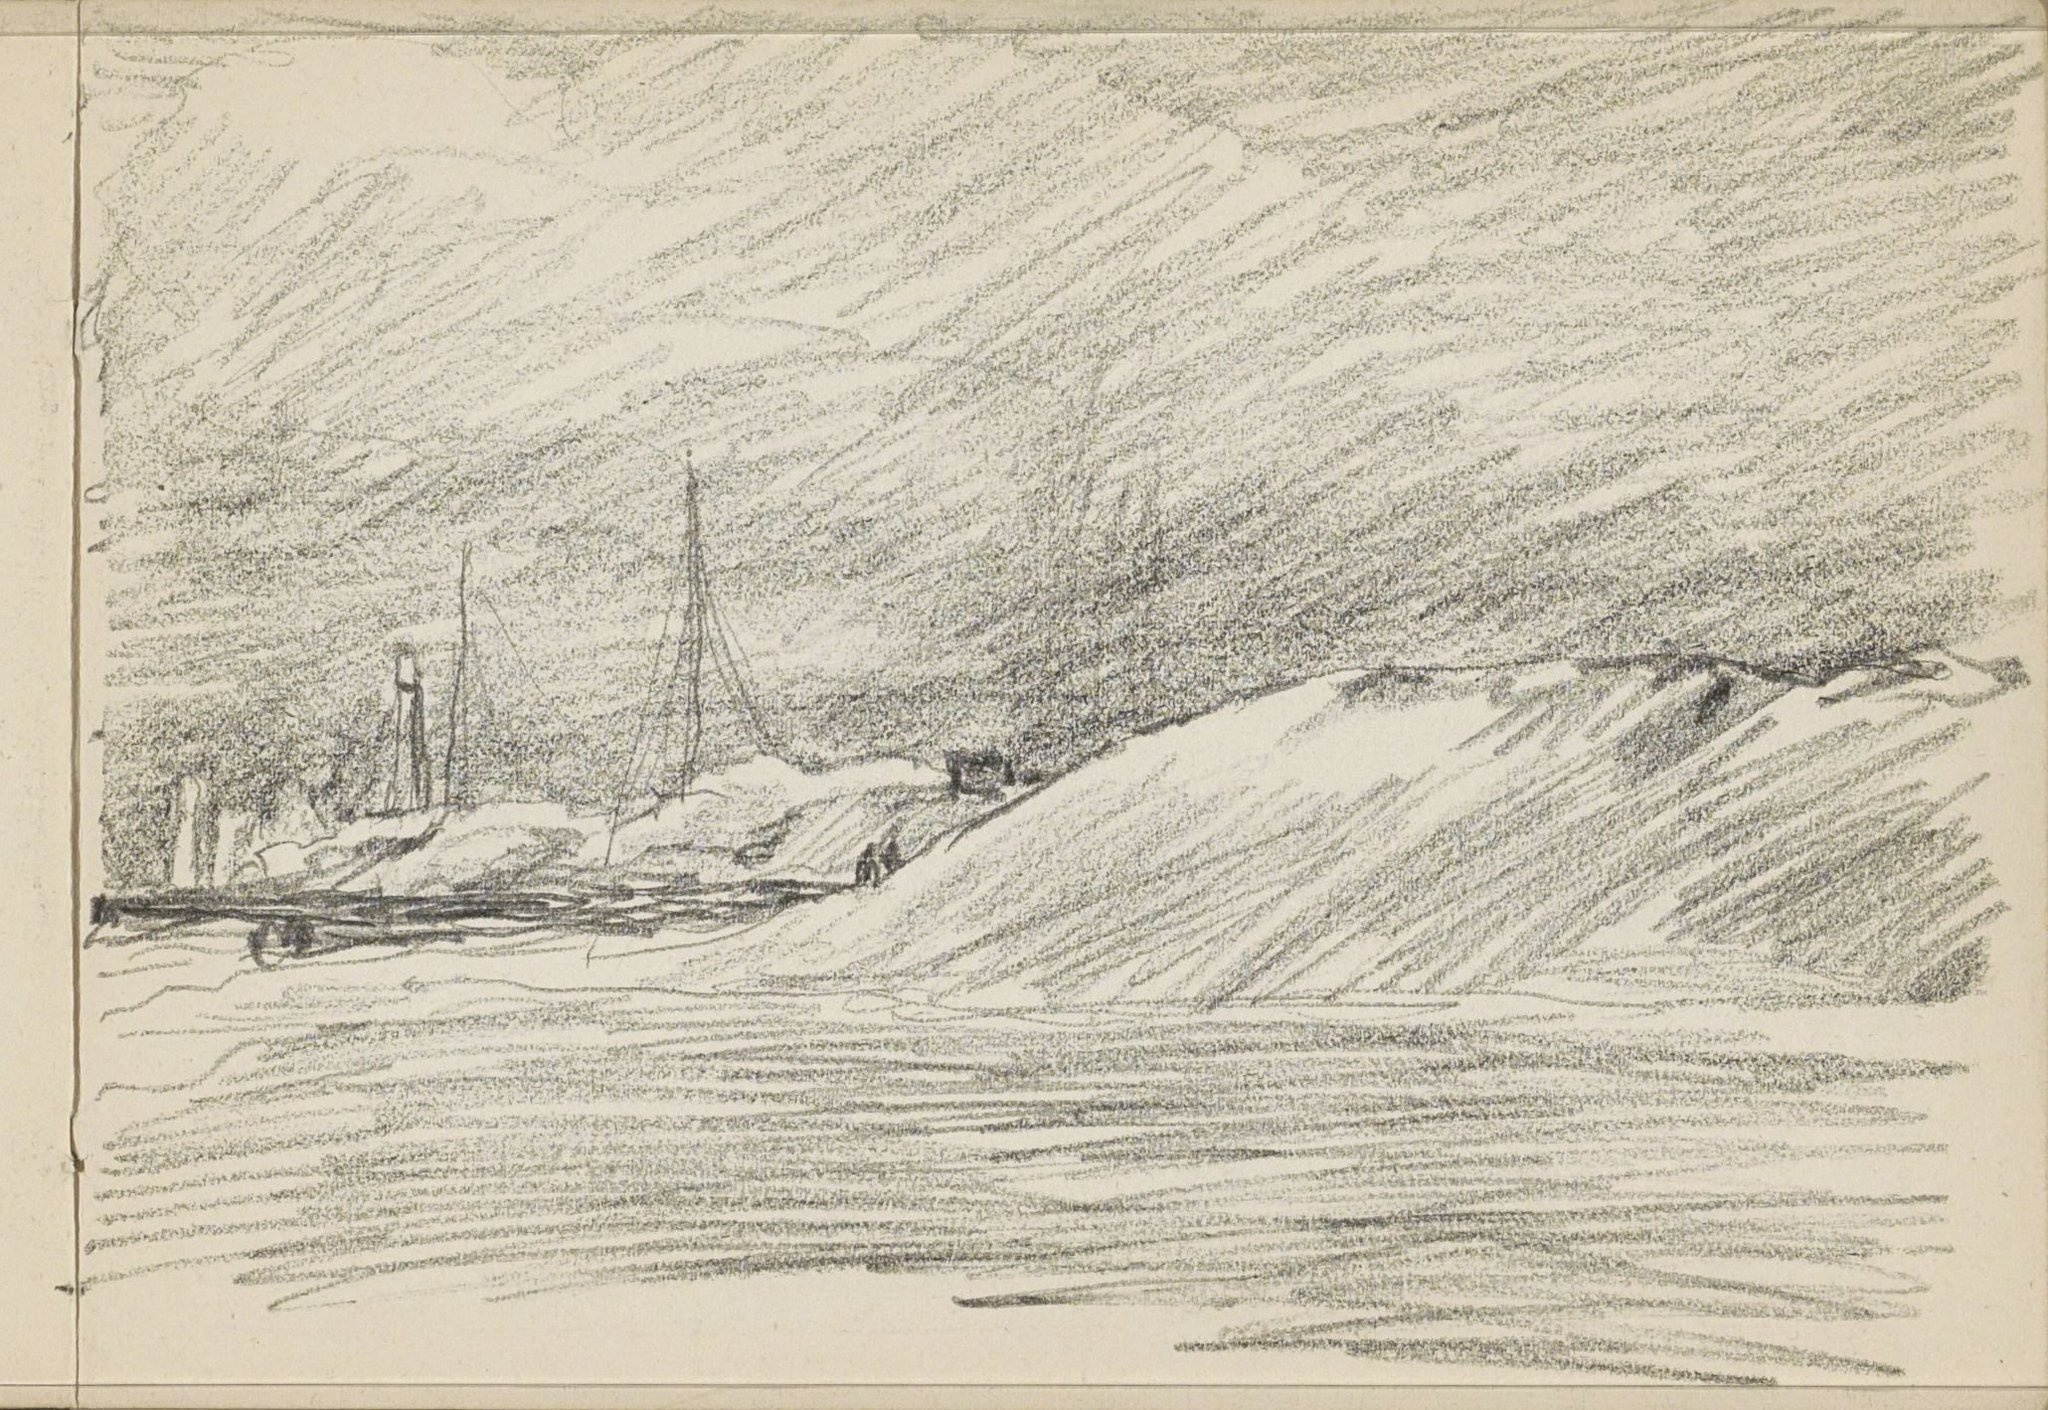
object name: sketchbook leaf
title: Duinlandschap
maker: alexander shilling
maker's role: draughtsman, print maker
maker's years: 1859-1937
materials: chalk, paper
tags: dune coast, sailing-ship, sailing-boat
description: Boven de duinen steken de masten van zeilschepen uit. Blad 6 recto uit een schetsboek met 30 bladen.